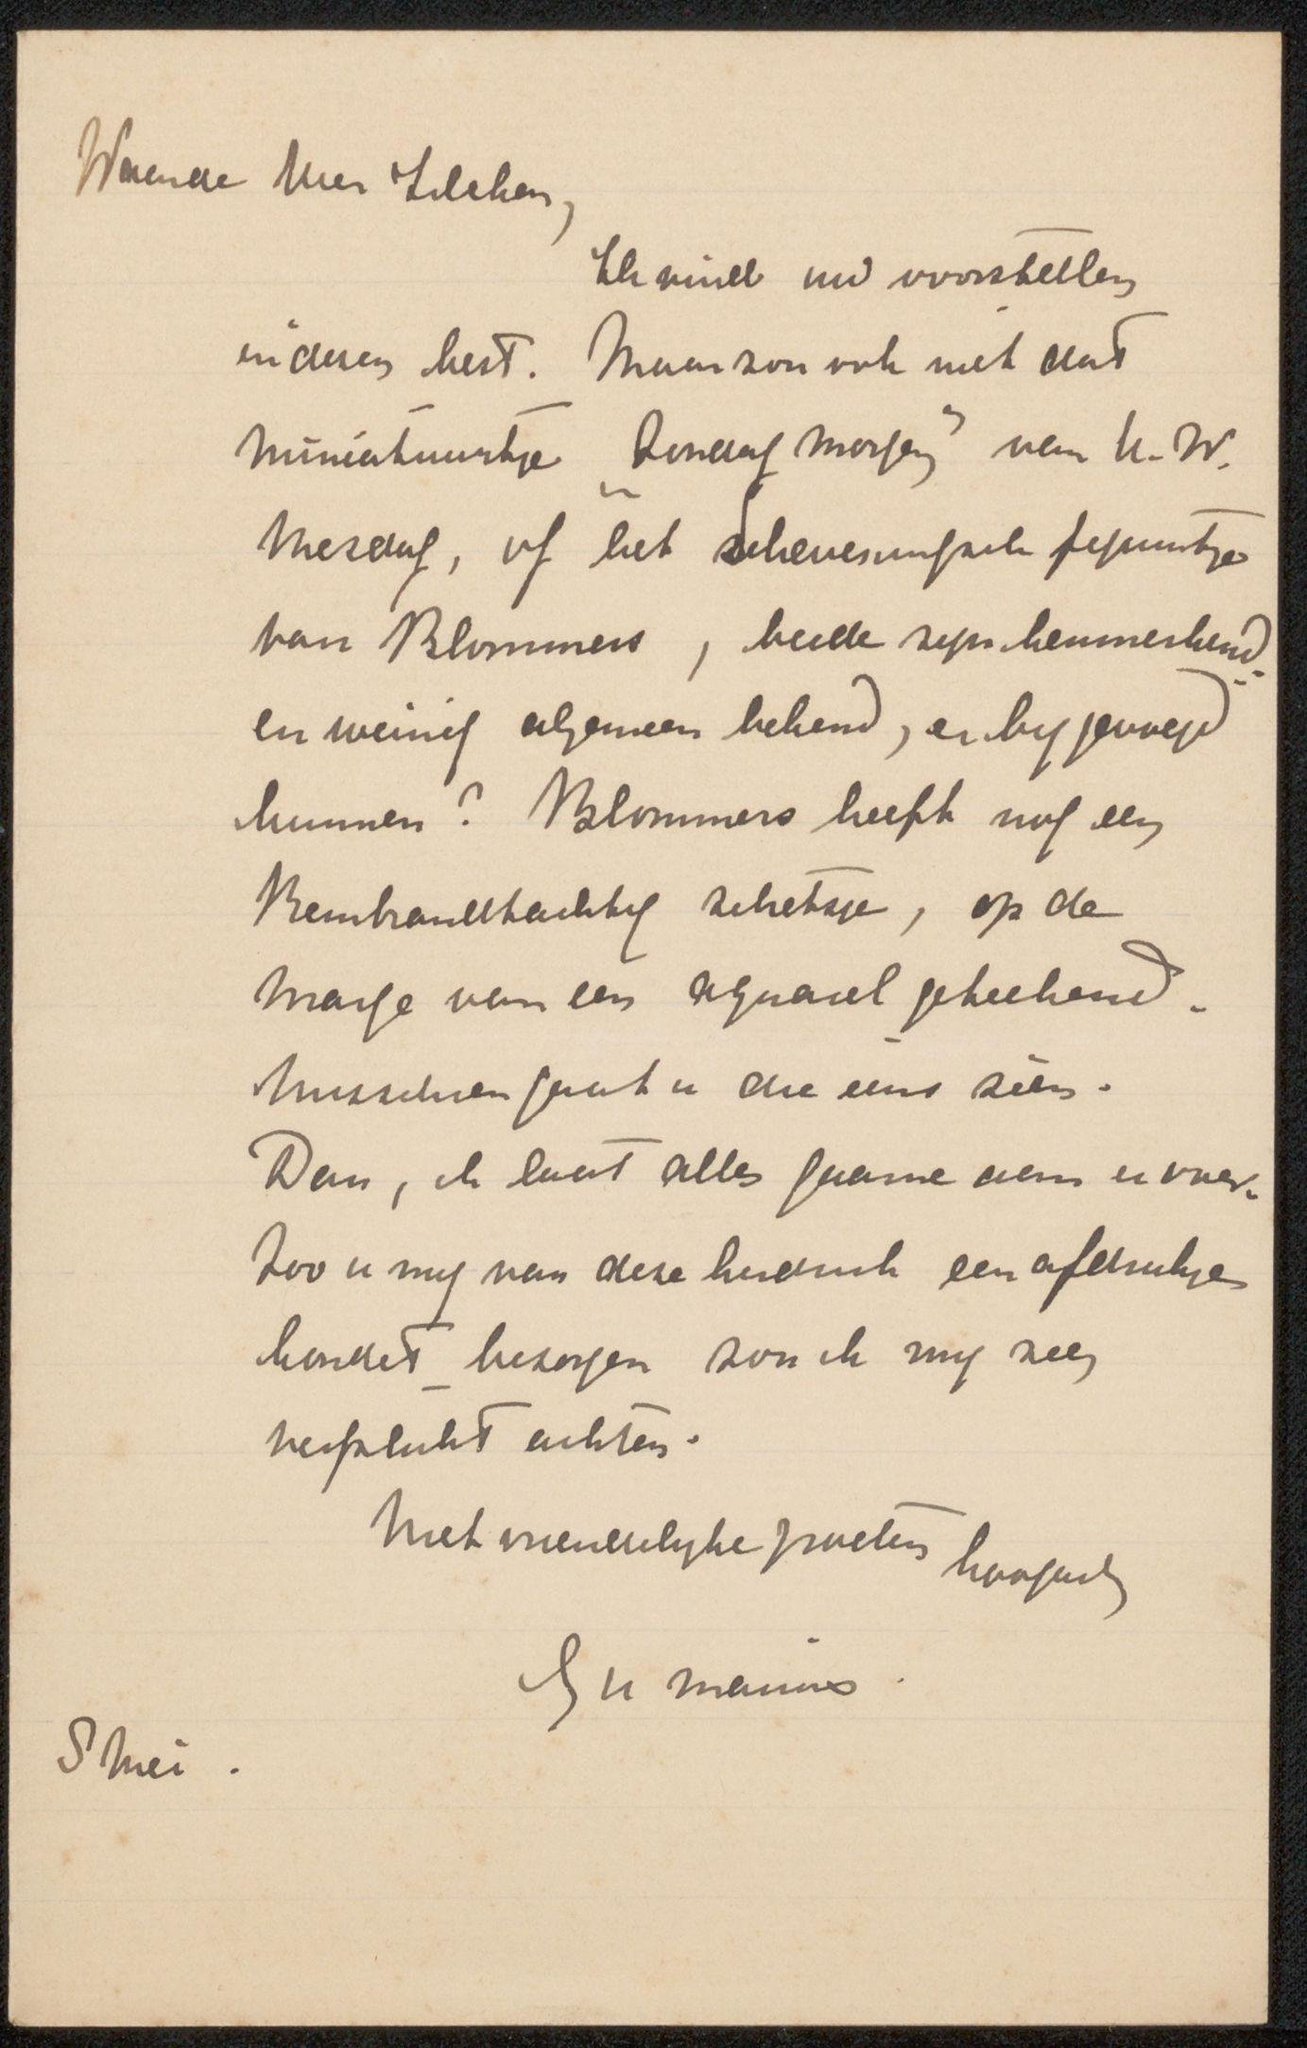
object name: letter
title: Brief aan Philip Zilcken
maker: grada hermina marius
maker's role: painter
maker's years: 1854-1919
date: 1900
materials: ink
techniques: pen, writing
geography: the hague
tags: print maker, draughtsman, bernardus johannes blommers, hendrik willem mesdag, philip zilcken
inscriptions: collector's mark: ‘RPK’